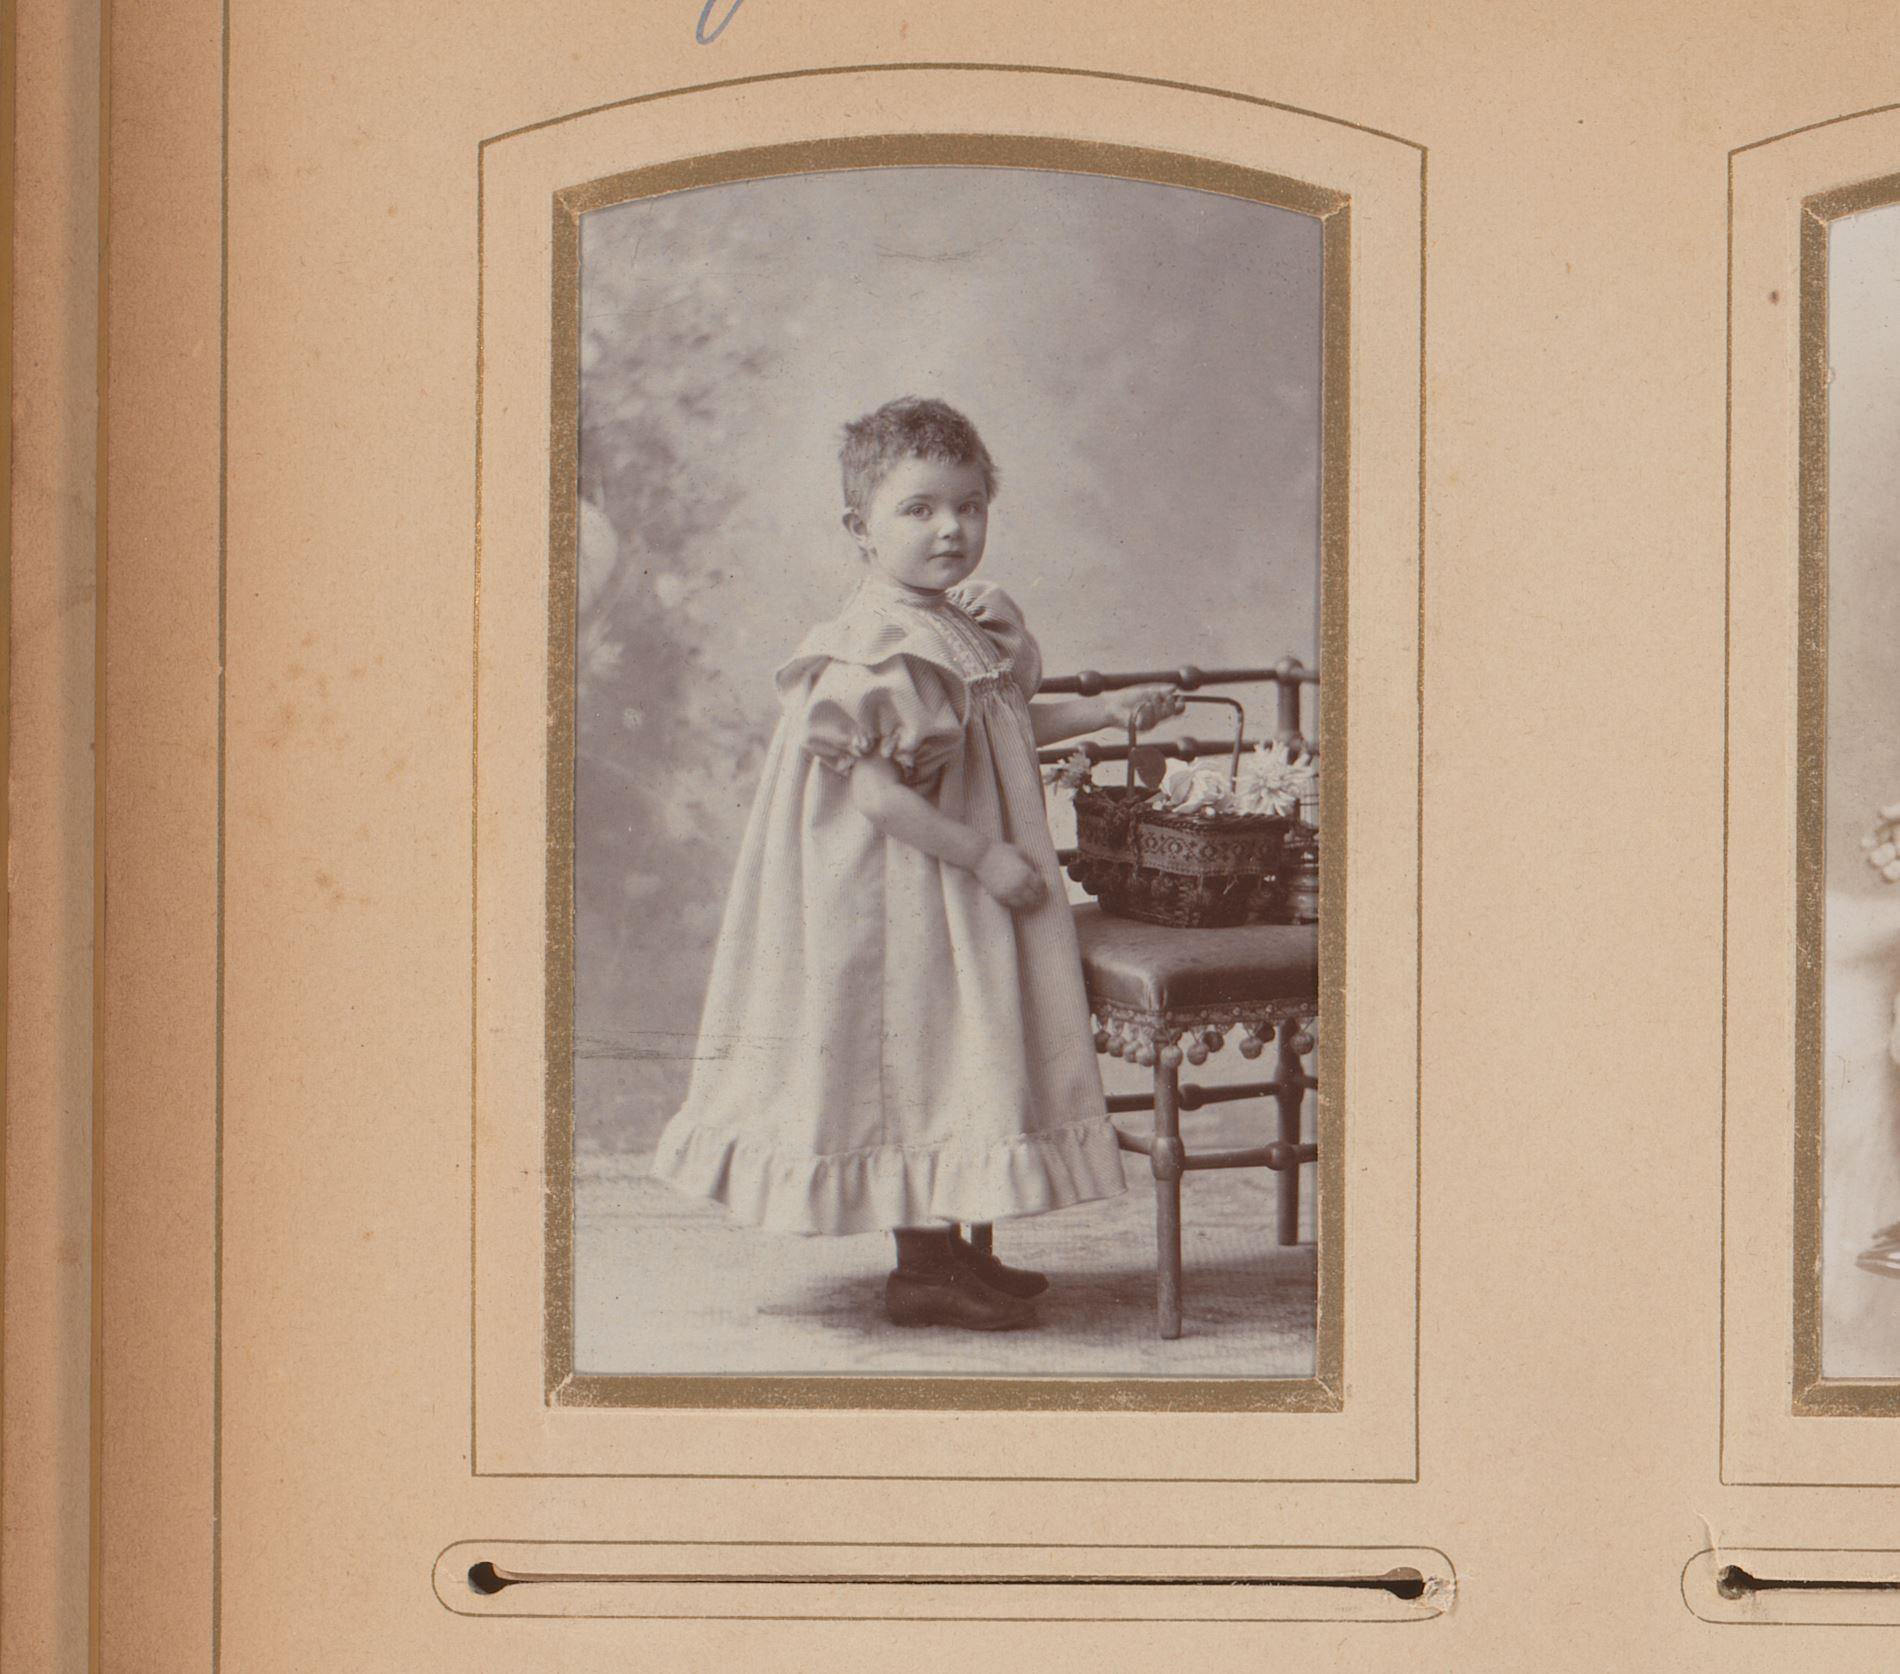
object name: carte de visite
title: Portret van Tootje Roos als peuter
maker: albert greiner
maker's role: fotograaf, fotostudio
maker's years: 1833-1890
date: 1883-1887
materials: cardboard, photographic support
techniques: collodion silver print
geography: amsterdam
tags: historical persons - bb - woman, toddler (female)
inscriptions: inscription: ‘Bekroond:/ Amsterdam 1877./ Paris 1878./ Arnhem 1879./ Amsterdam 1883./ Albert Greiner/ Photograaf van wijlen Z.M. den Koning/ Willem III en van H.M. de Koningin Weduwe/ Amsterdam/ Nieuwendijk 89./ Specialiteit in Vergrootingen./ Clichés worden voor nabestelling bewaard.’, number: ‘180B.’, name: ‘Tootje Roos’